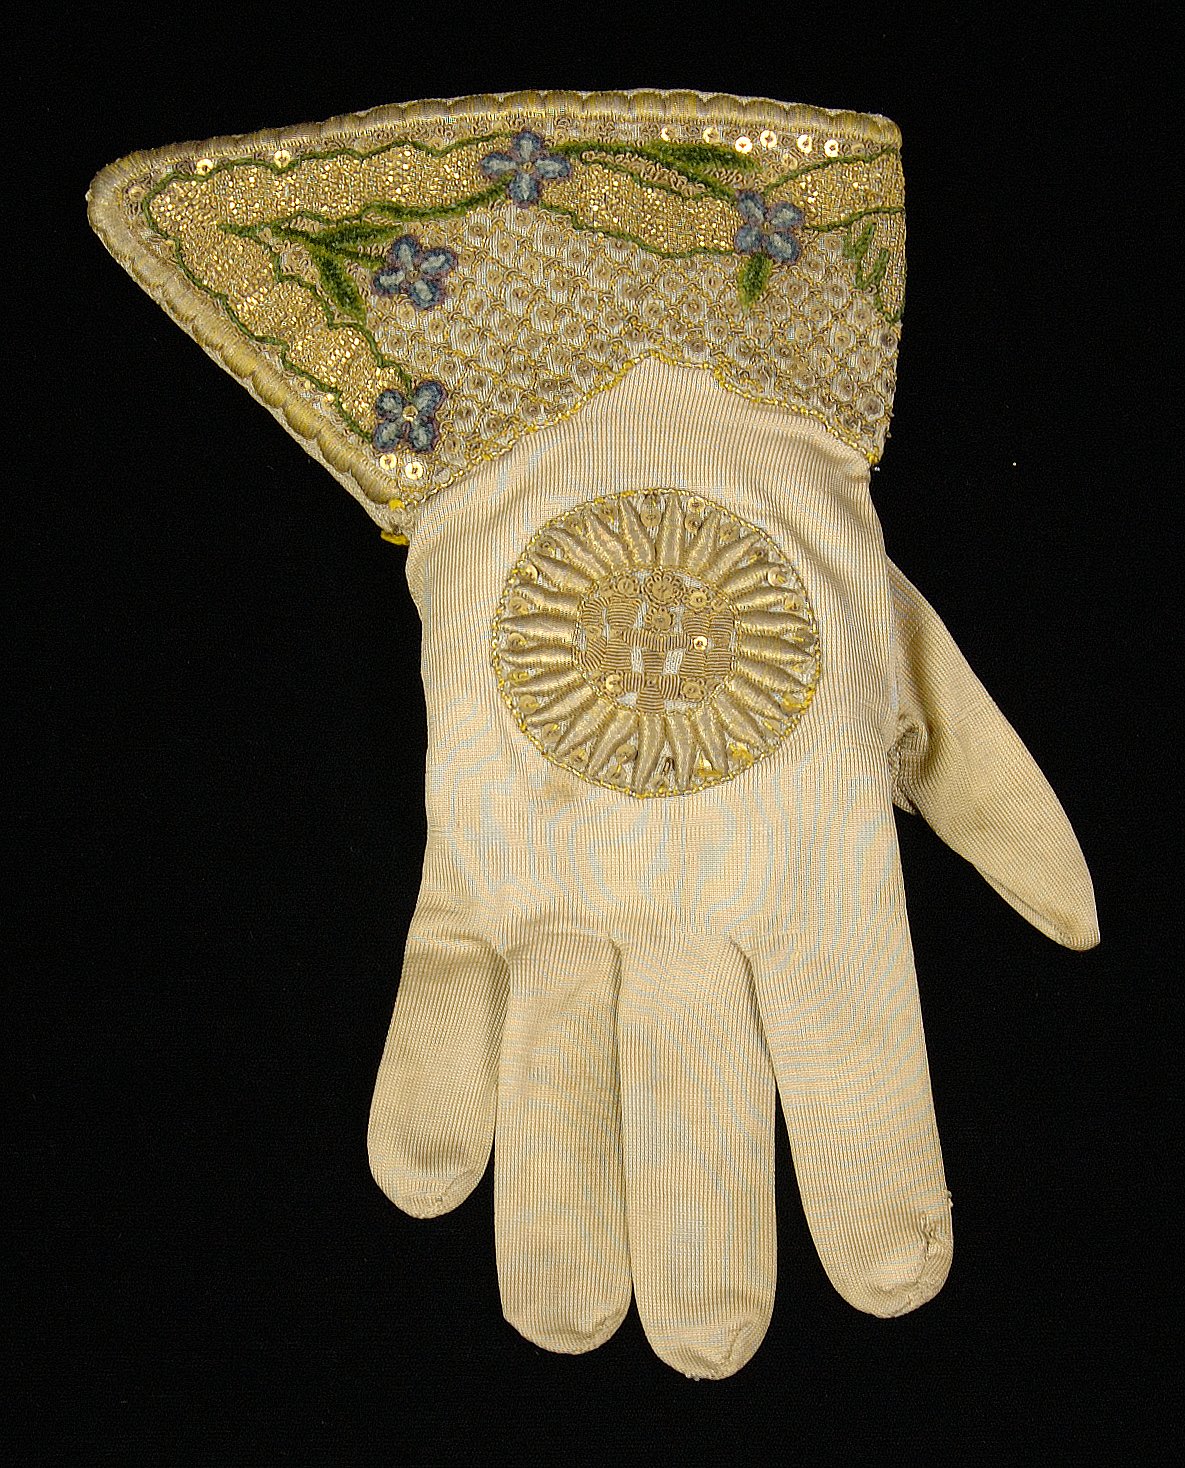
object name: glove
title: Bishop's Gloves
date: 1701-1725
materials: metal, silk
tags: flowers